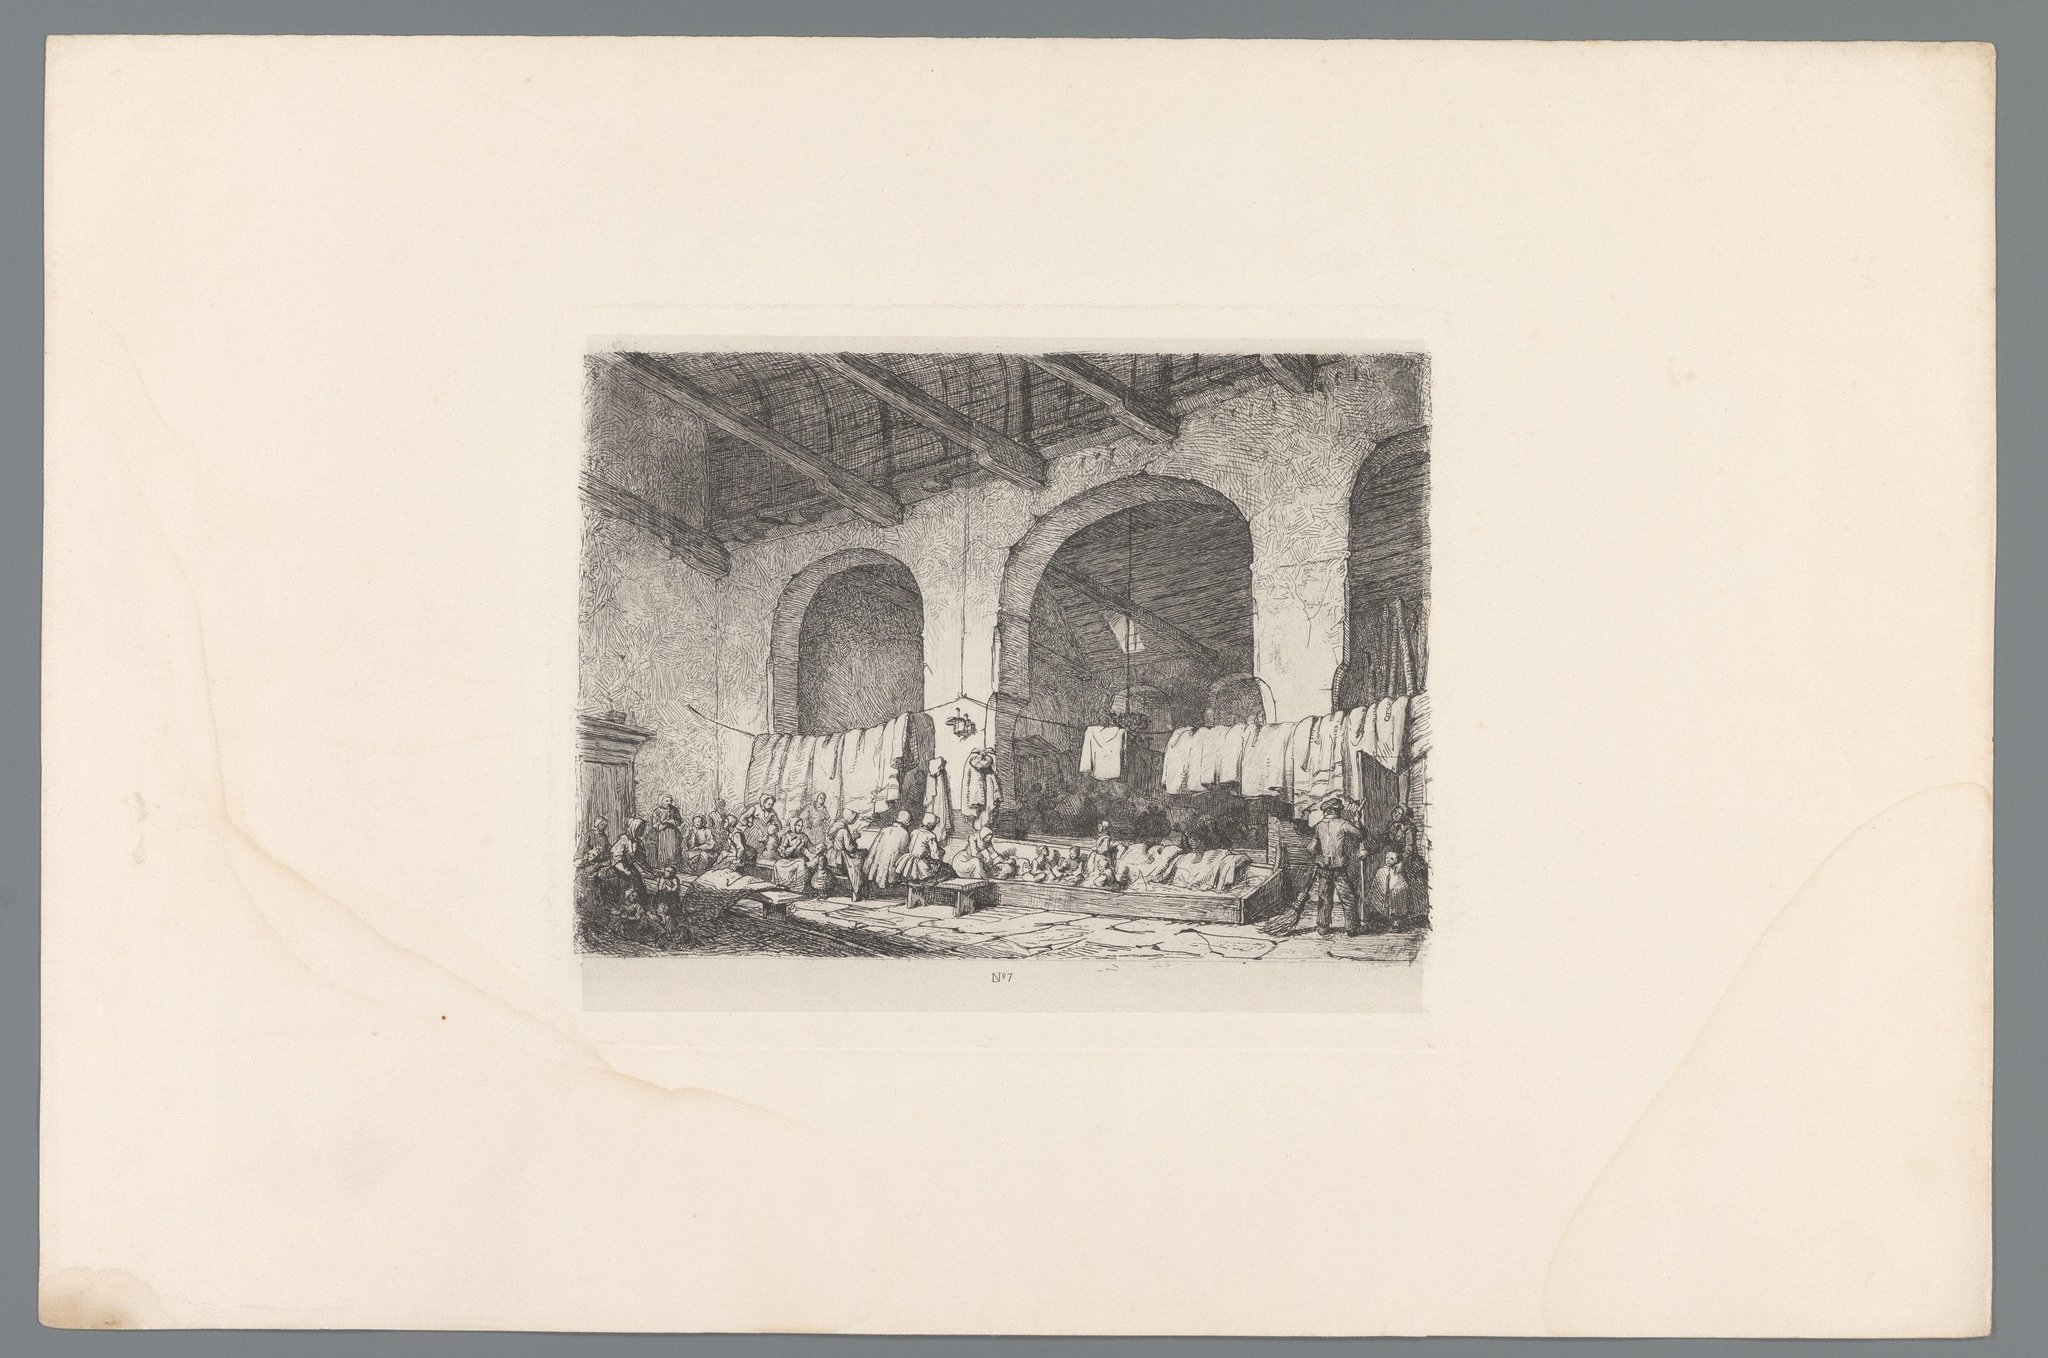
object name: print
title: De Waterramp van 1855. Geschetst in 24 afbeeldingen, naar de natuur geteekend en geëtst door leden der Maatschappij Arti et Amicitiae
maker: david van der kellen (1804-1879)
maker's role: die cutter, draughtsman, print maker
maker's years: 1804-1879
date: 1855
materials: paper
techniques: drypoint, etching, intaglio, roulette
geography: netherlands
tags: interior of church, flood